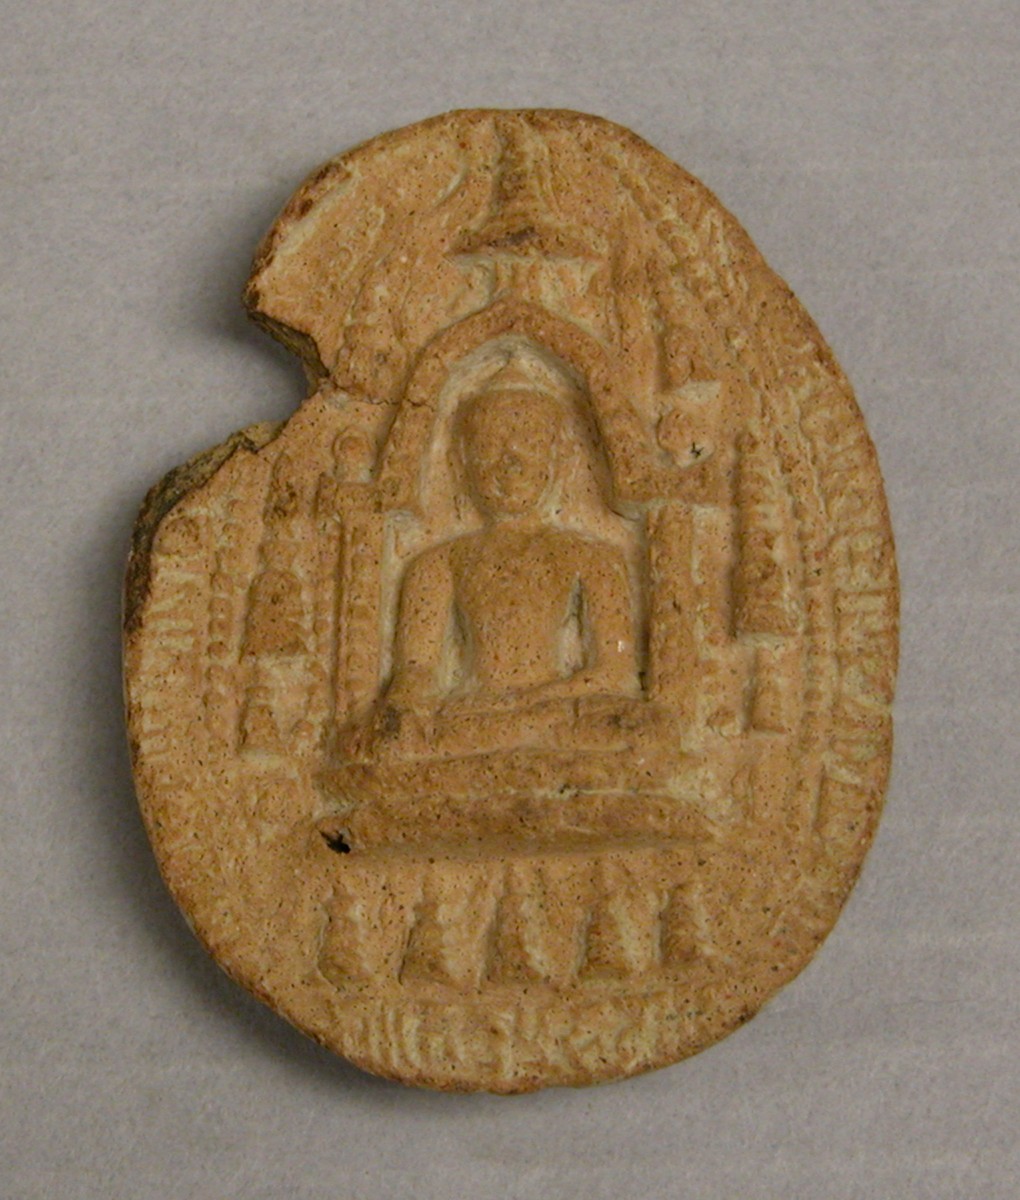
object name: votive plaque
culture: indian or thai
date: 1001-1200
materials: terracotta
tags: buddhism,buddha,stupas